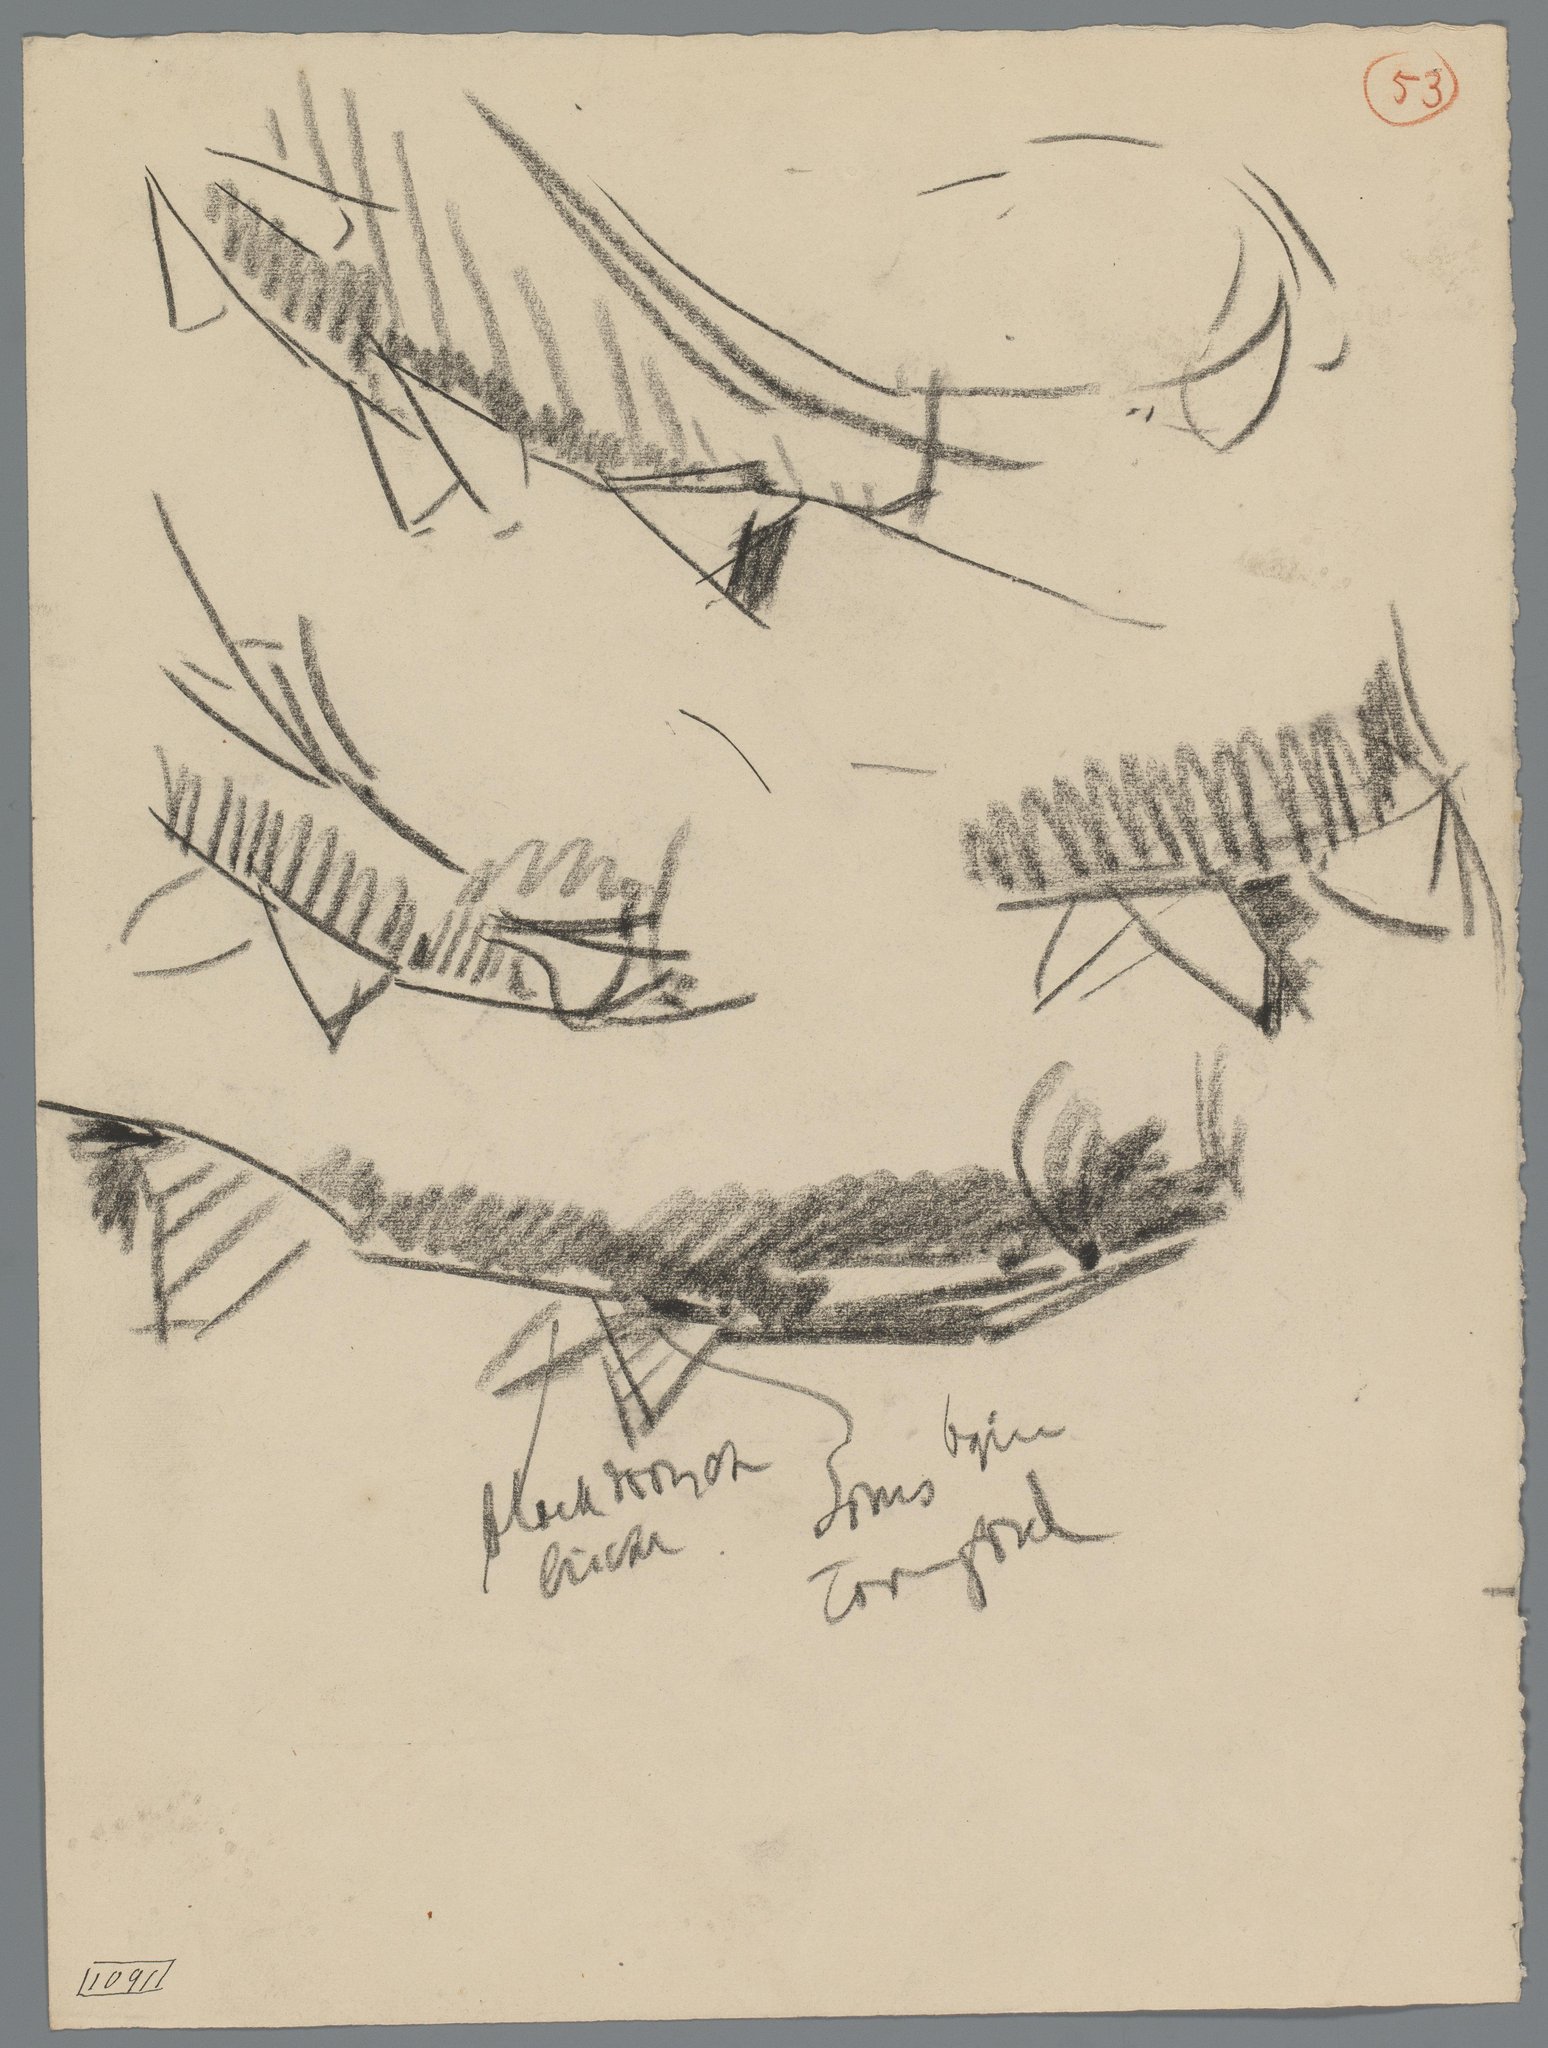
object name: drawing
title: Studieblad met vinnen van karpers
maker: gerrit willem dijsselhof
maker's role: designer, draughtsman, print maker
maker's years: 1866-1924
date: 1876-1924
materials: chalk, paper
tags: bony fishes: carp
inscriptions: number: ‘1091’